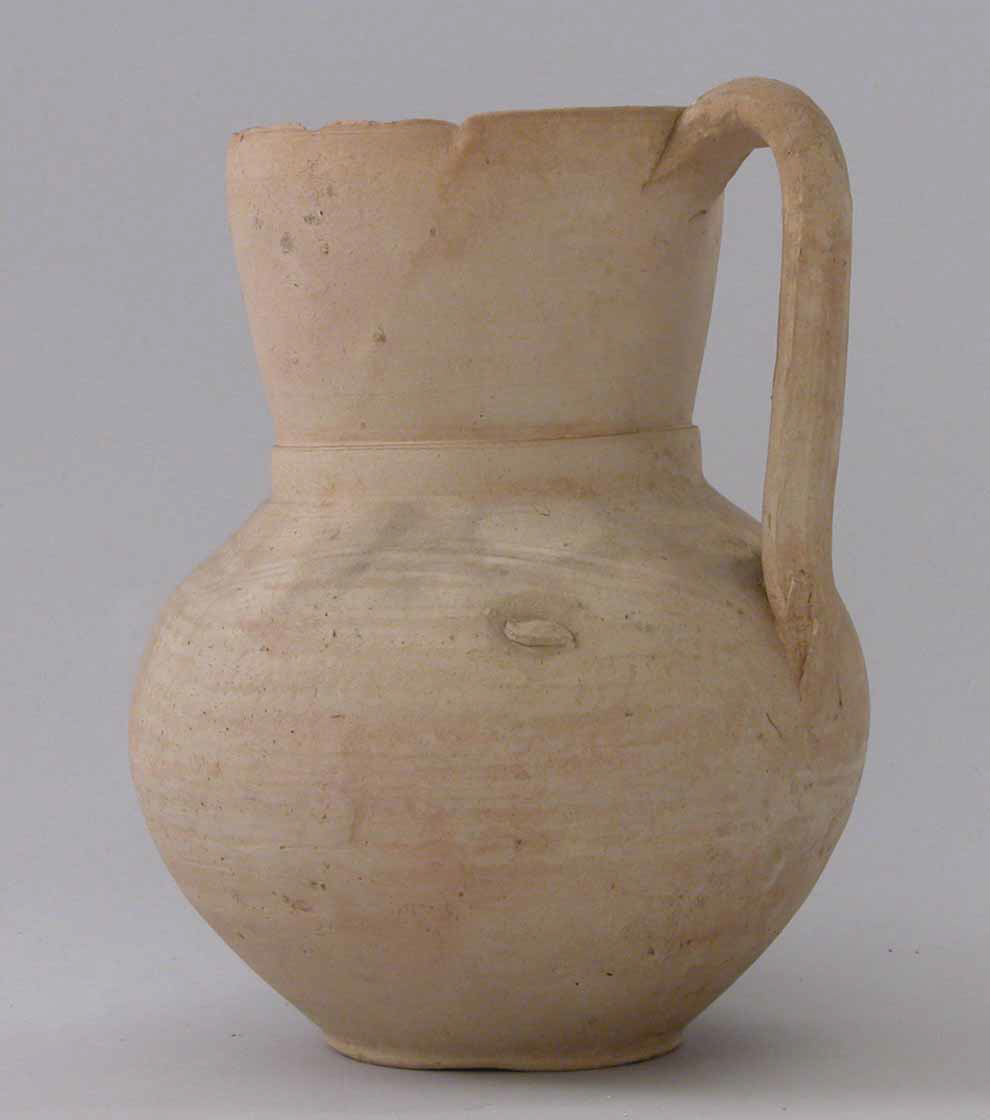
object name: ewer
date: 801-933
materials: earthenware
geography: iran